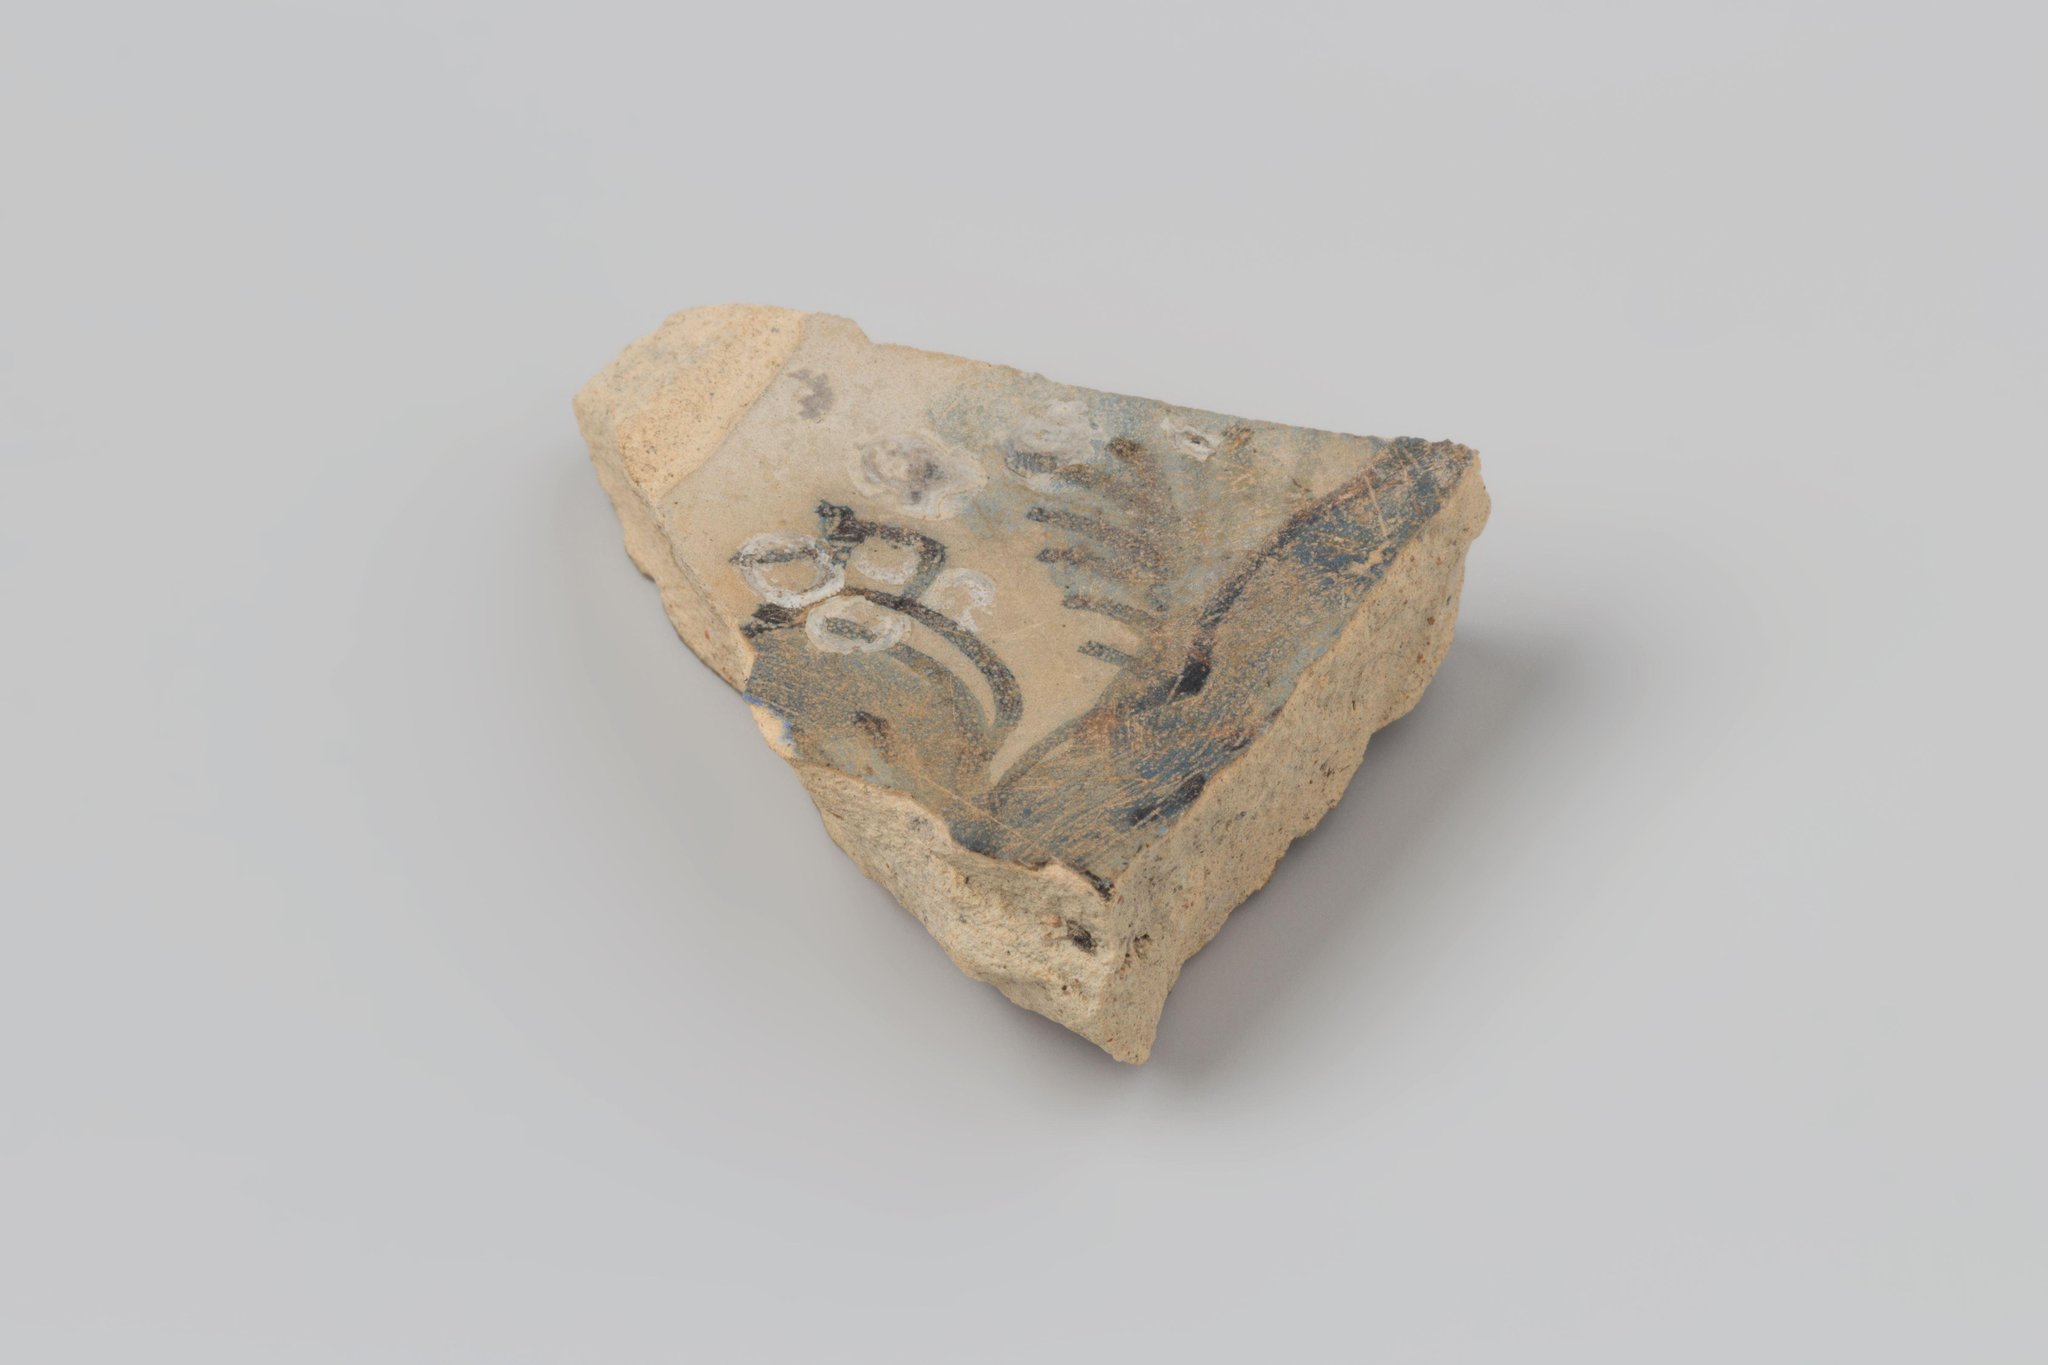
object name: sherd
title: Scherf van een bord uit het wrak van de Oost-Indiëvaarder 't Vliegend Hart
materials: glaze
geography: netherlands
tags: 't vliegend hart (schip), verenigde oostindische compagnie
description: Dikke scherf geelbakkend aardewerk die deel heeft uitgemaakt van een bord, geelwit met blauwe tekening.